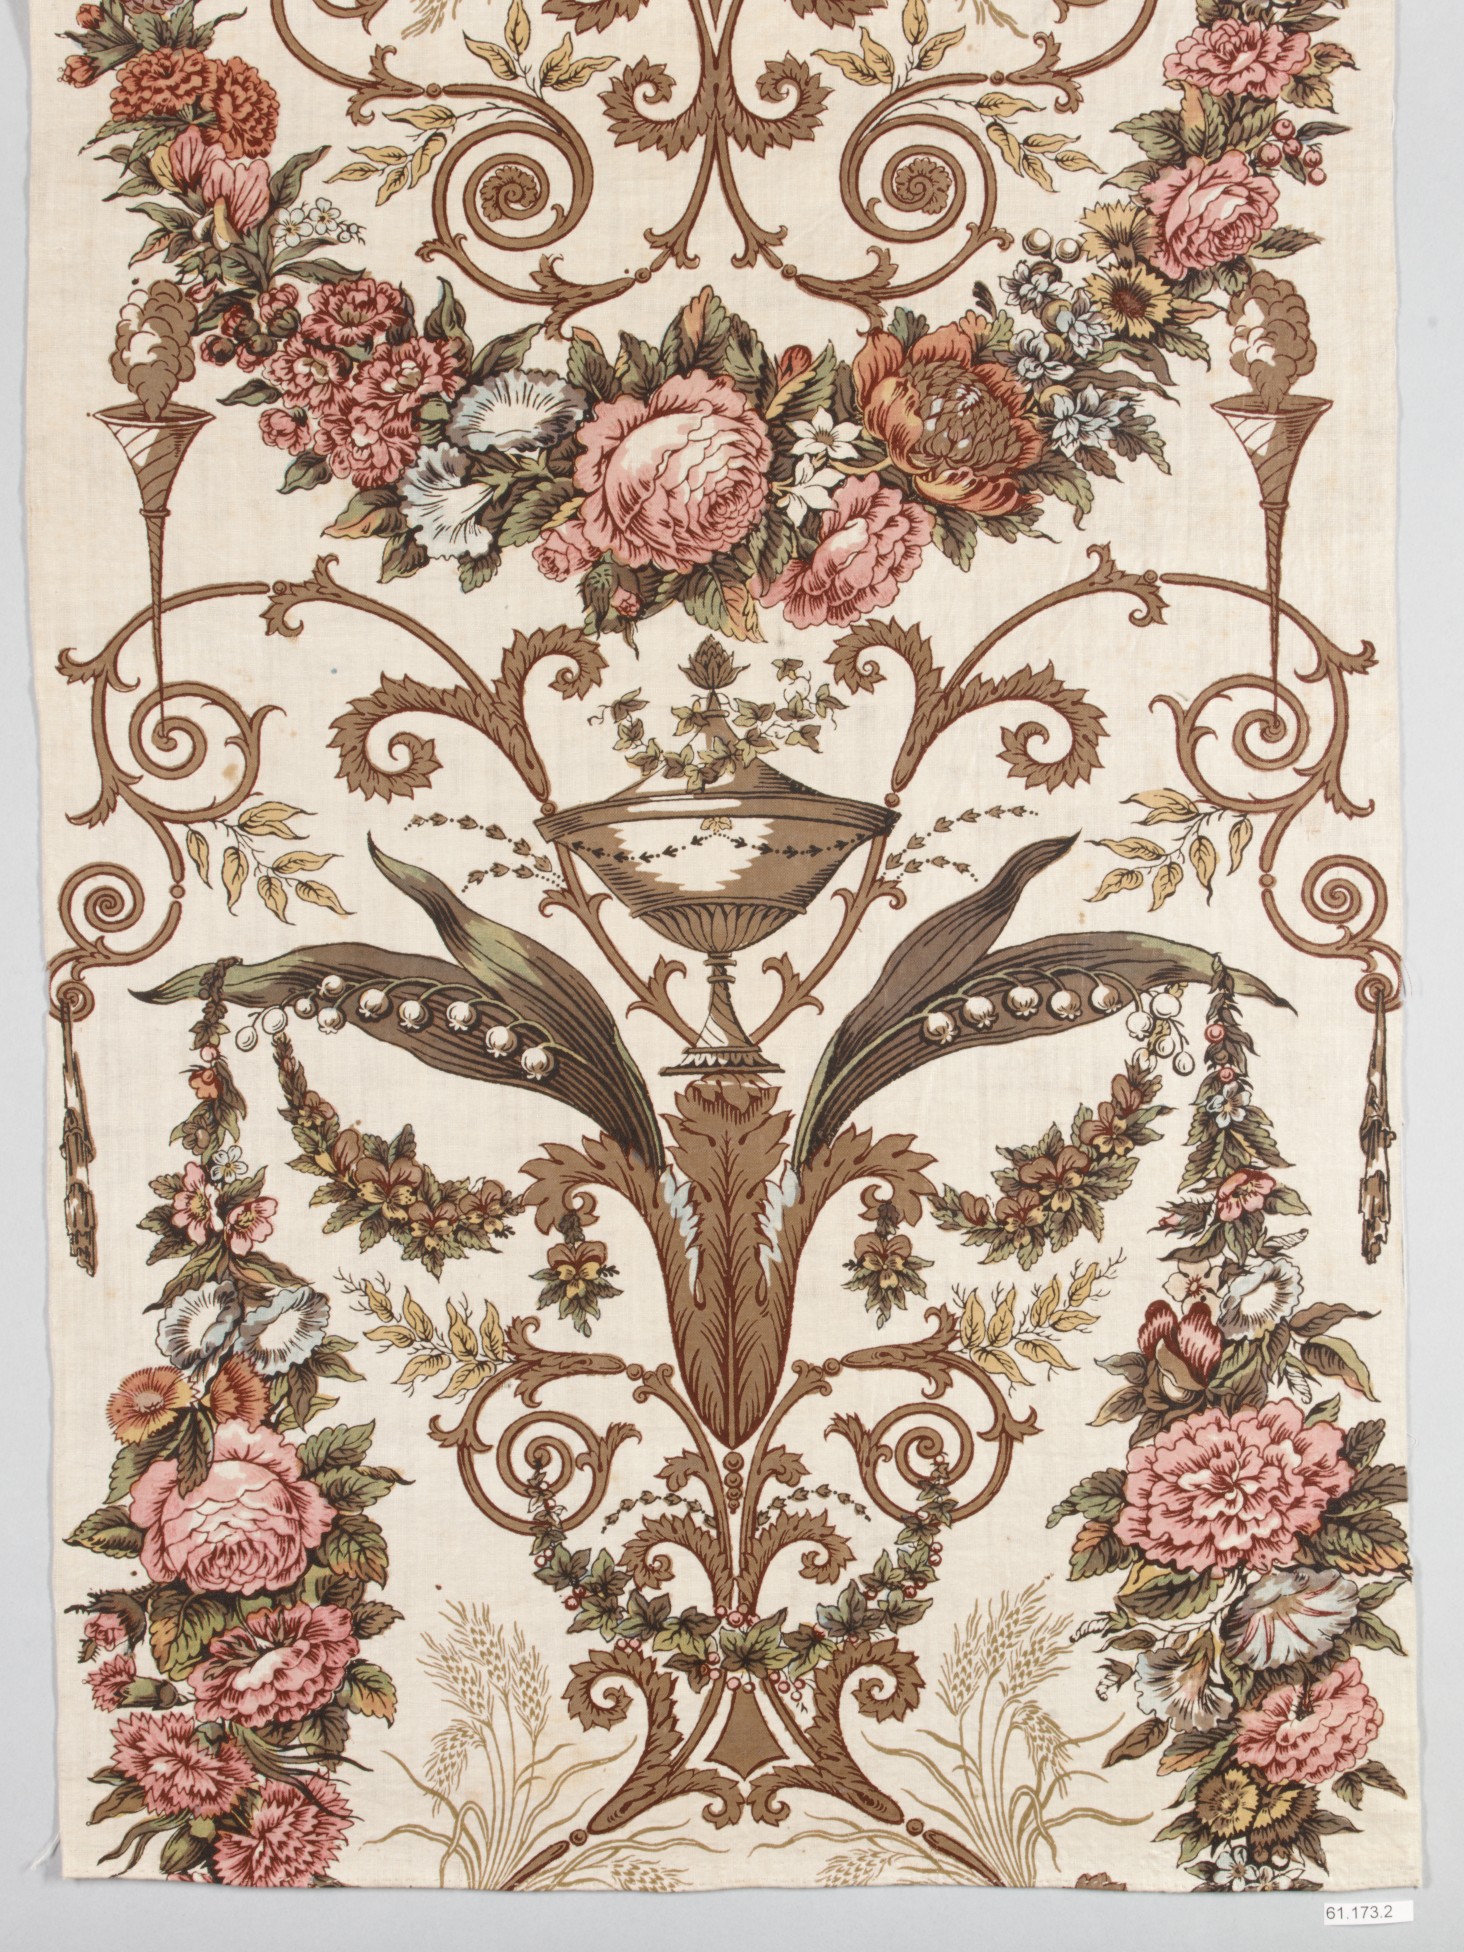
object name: piece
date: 1801-1833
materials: cotton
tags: flowers,leaves